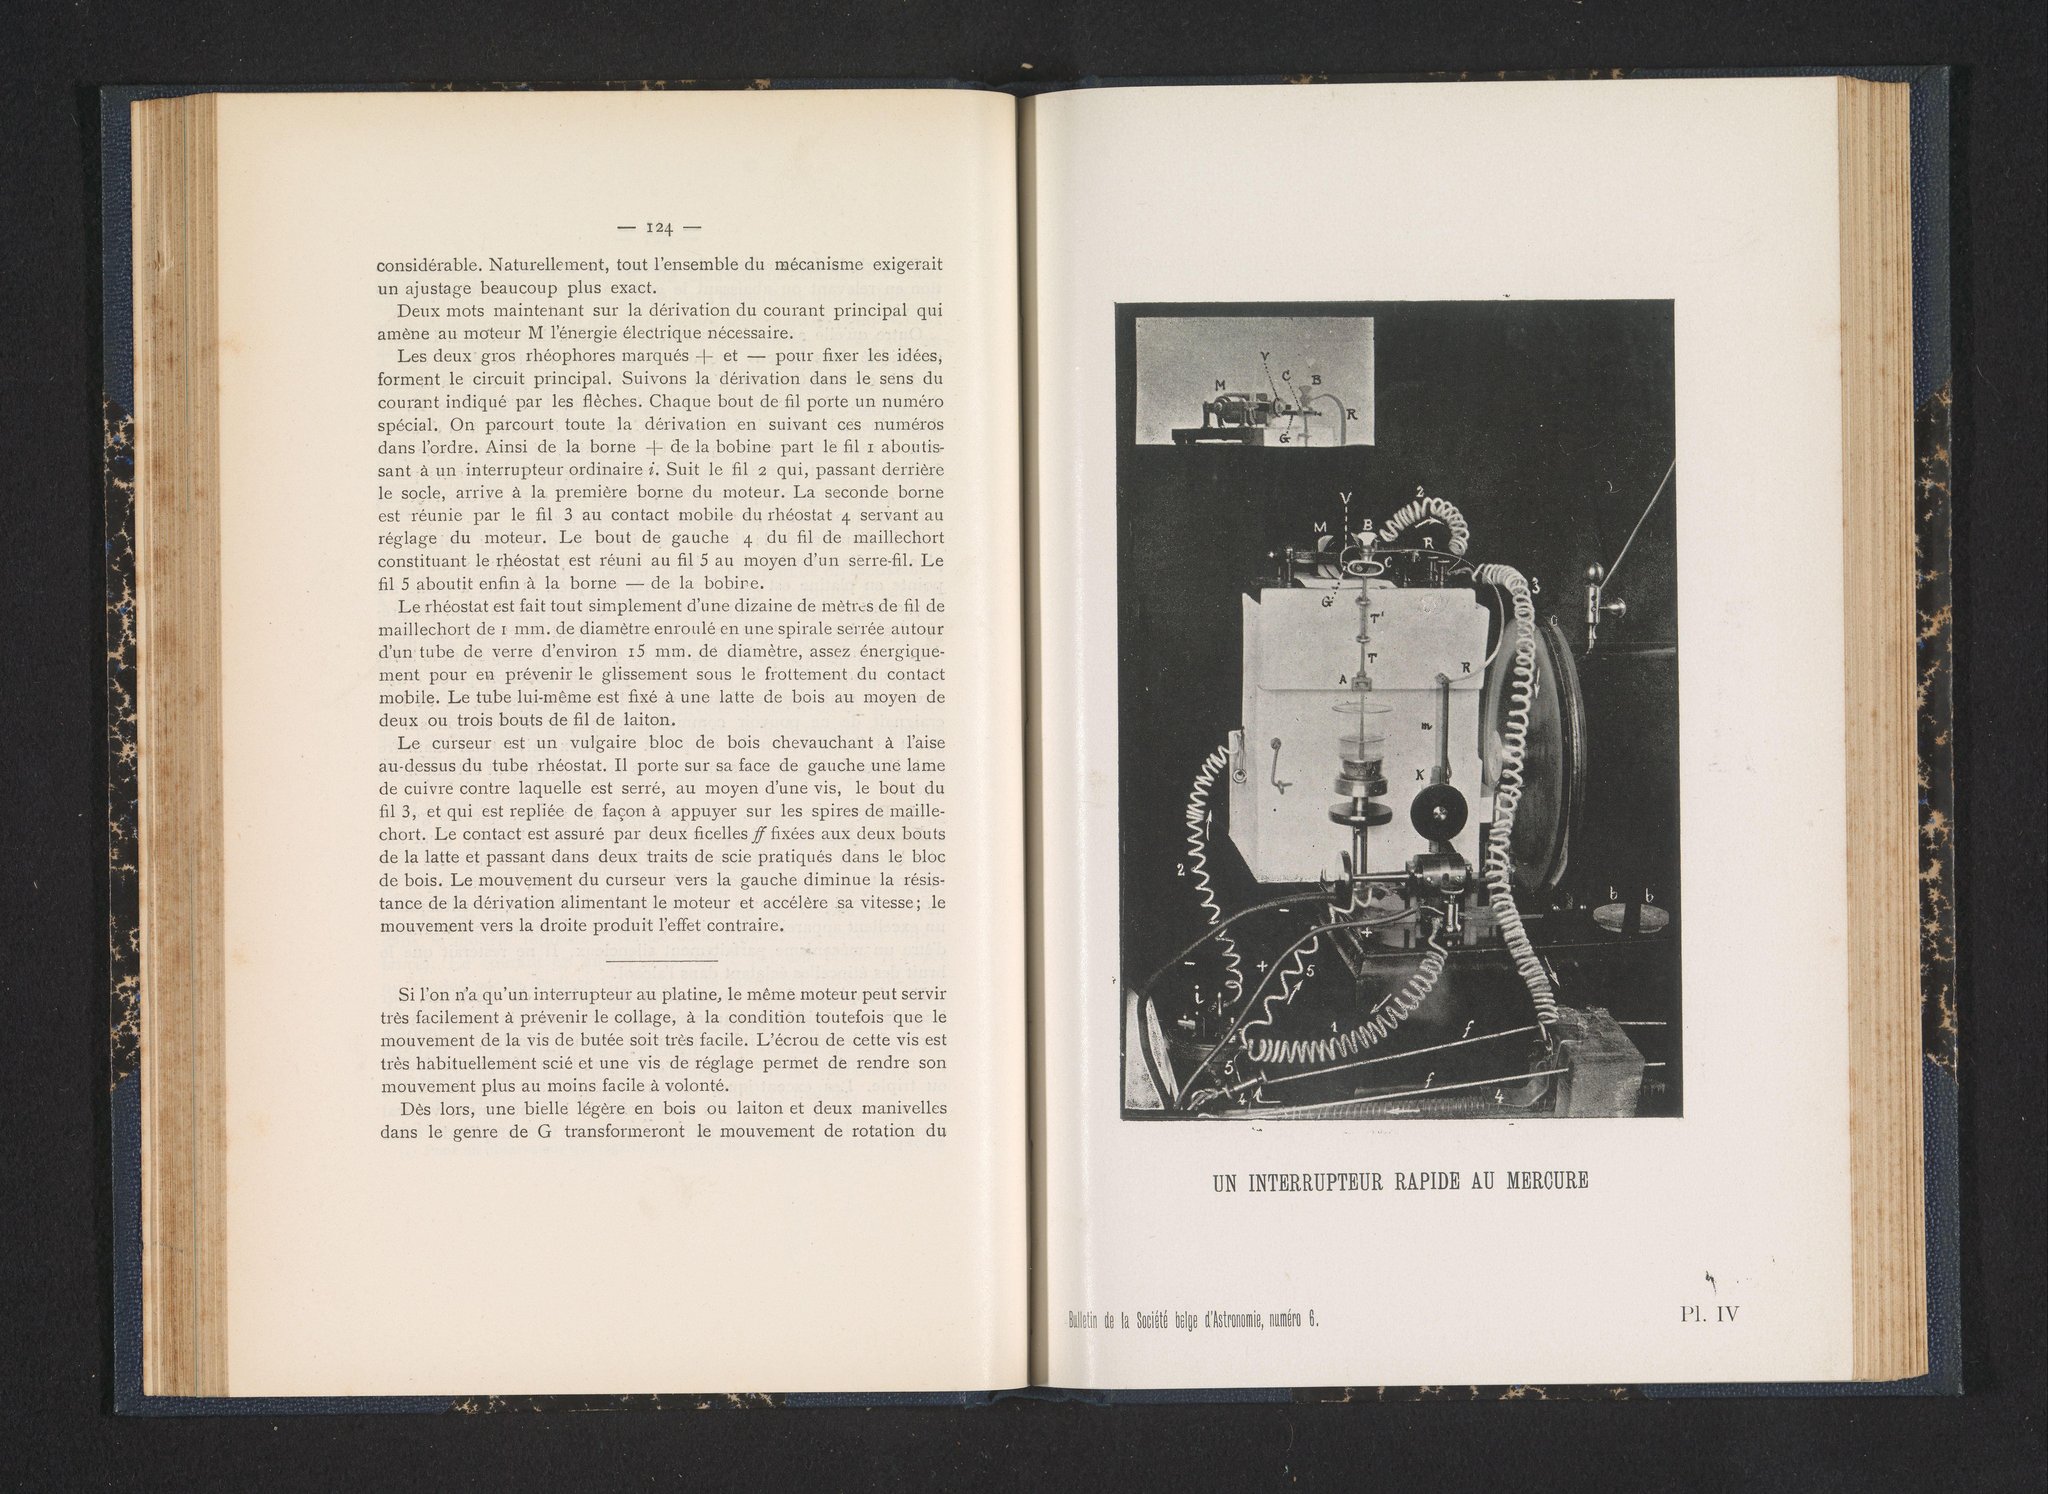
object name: page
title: Un interrupteur rapide au mercure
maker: Anonymous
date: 1891-1897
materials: paper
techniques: autotype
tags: chemistry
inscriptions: inscription: ‘Pl IV’